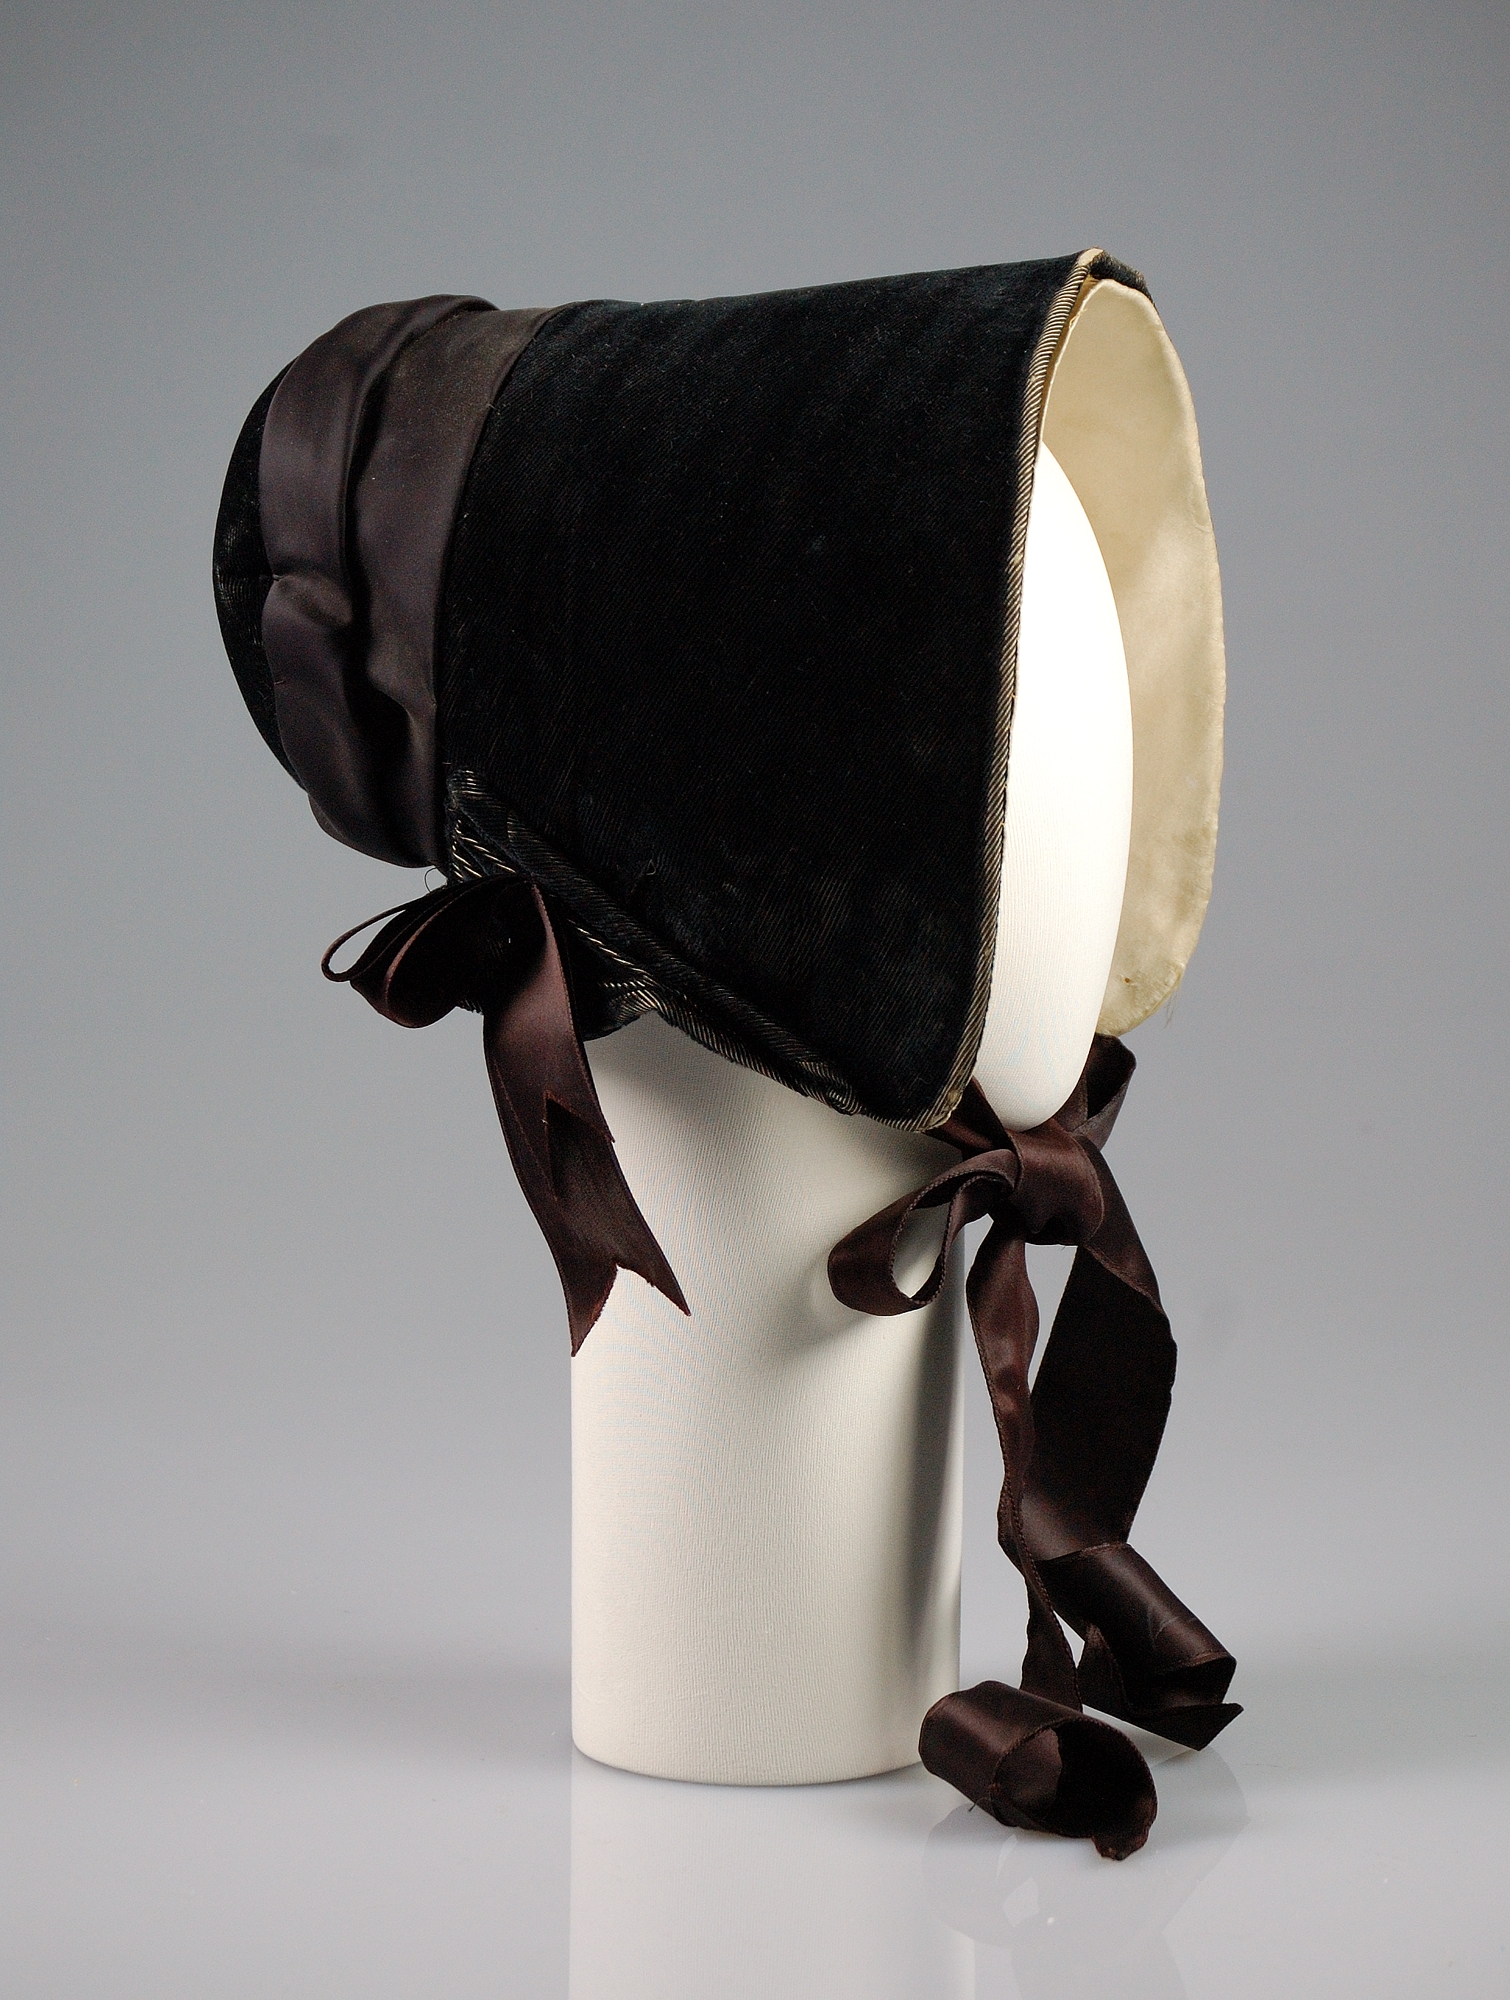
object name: bonnet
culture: american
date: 1845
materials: silk